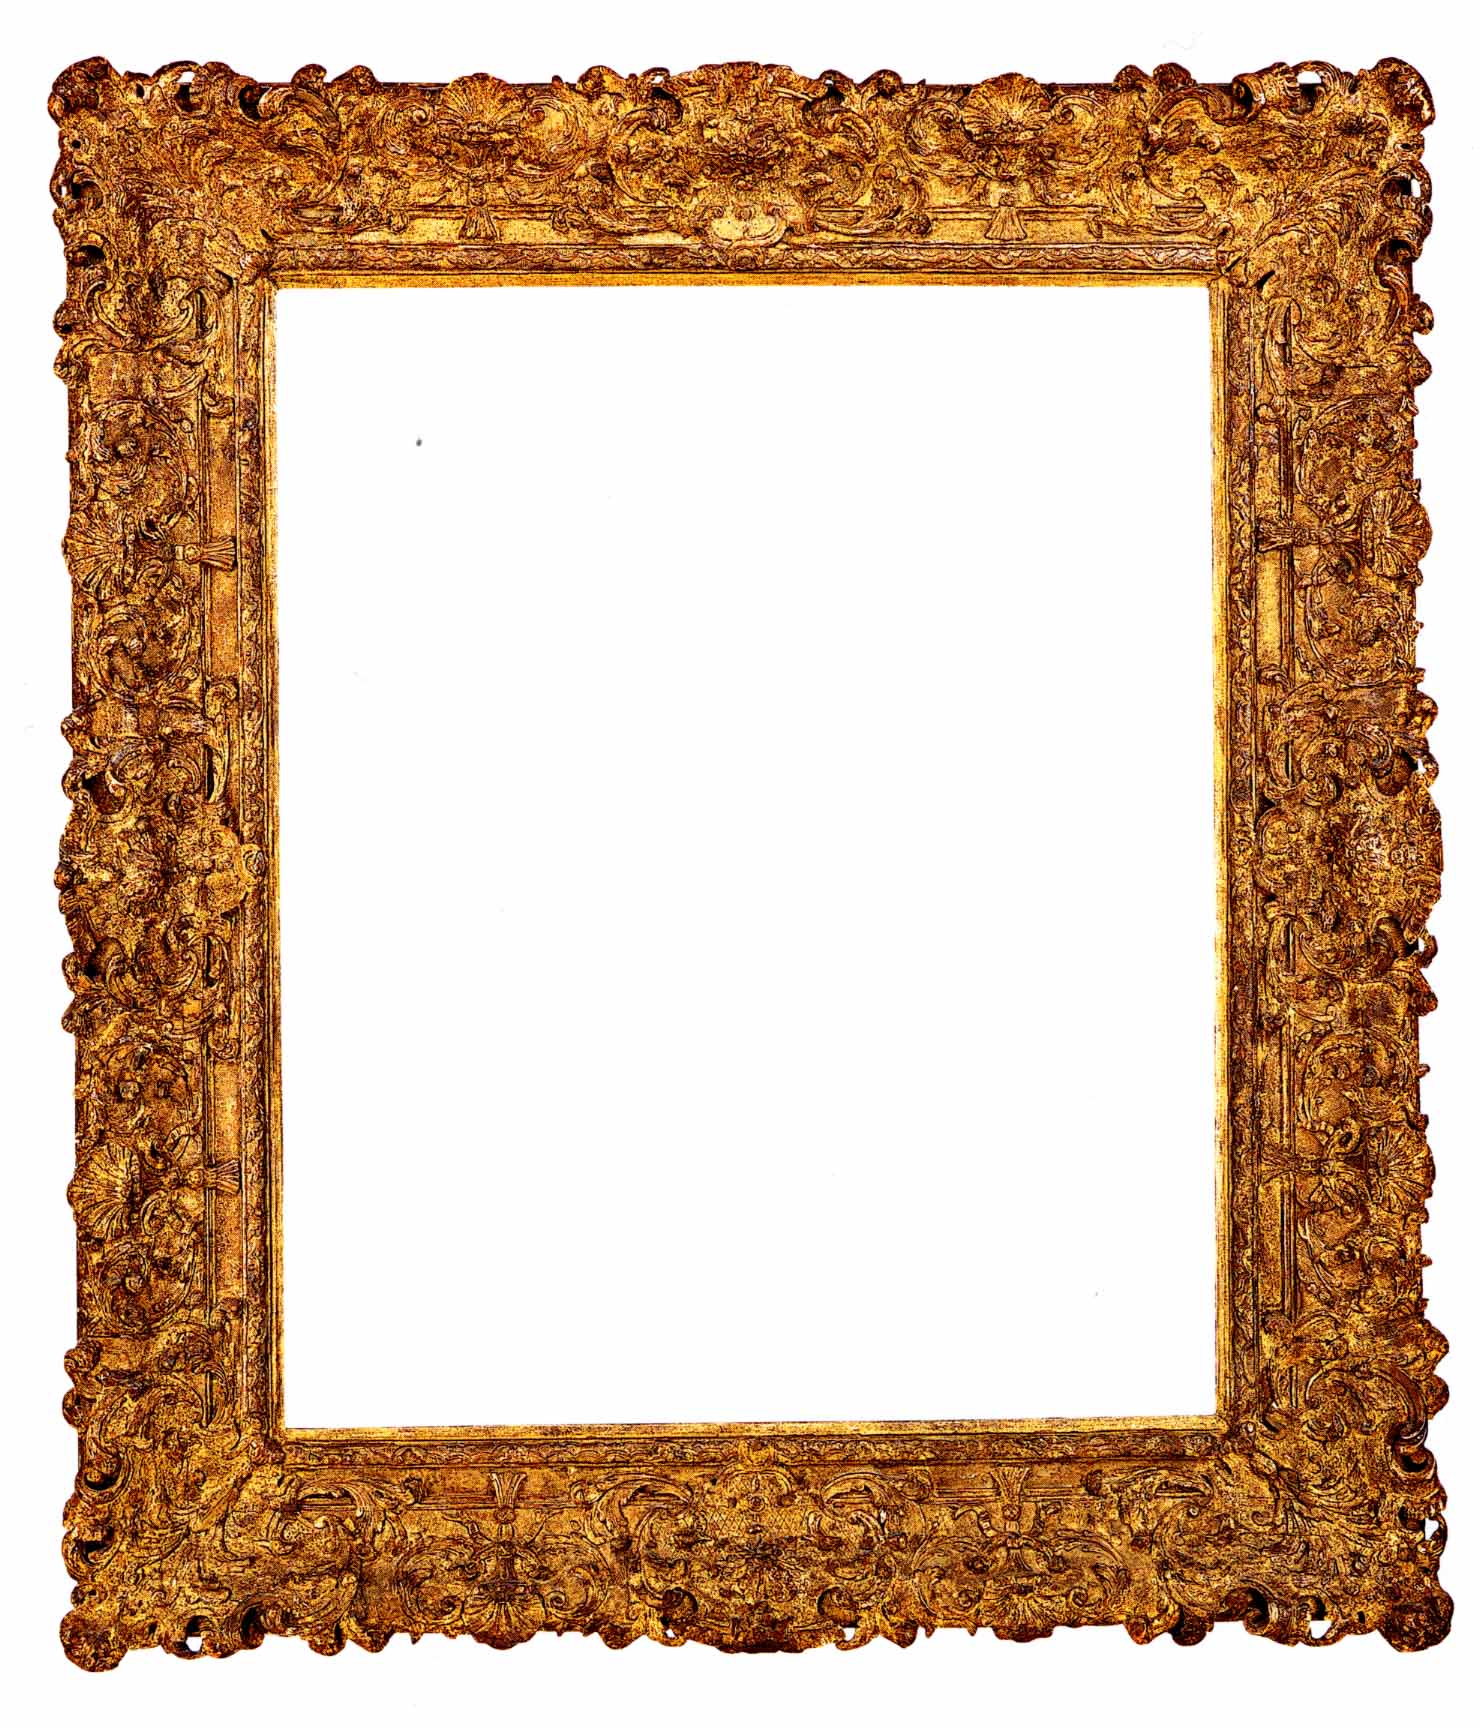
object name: frame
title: Ogee frame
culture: french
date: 1700-1720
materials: gilt, wood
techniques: carving